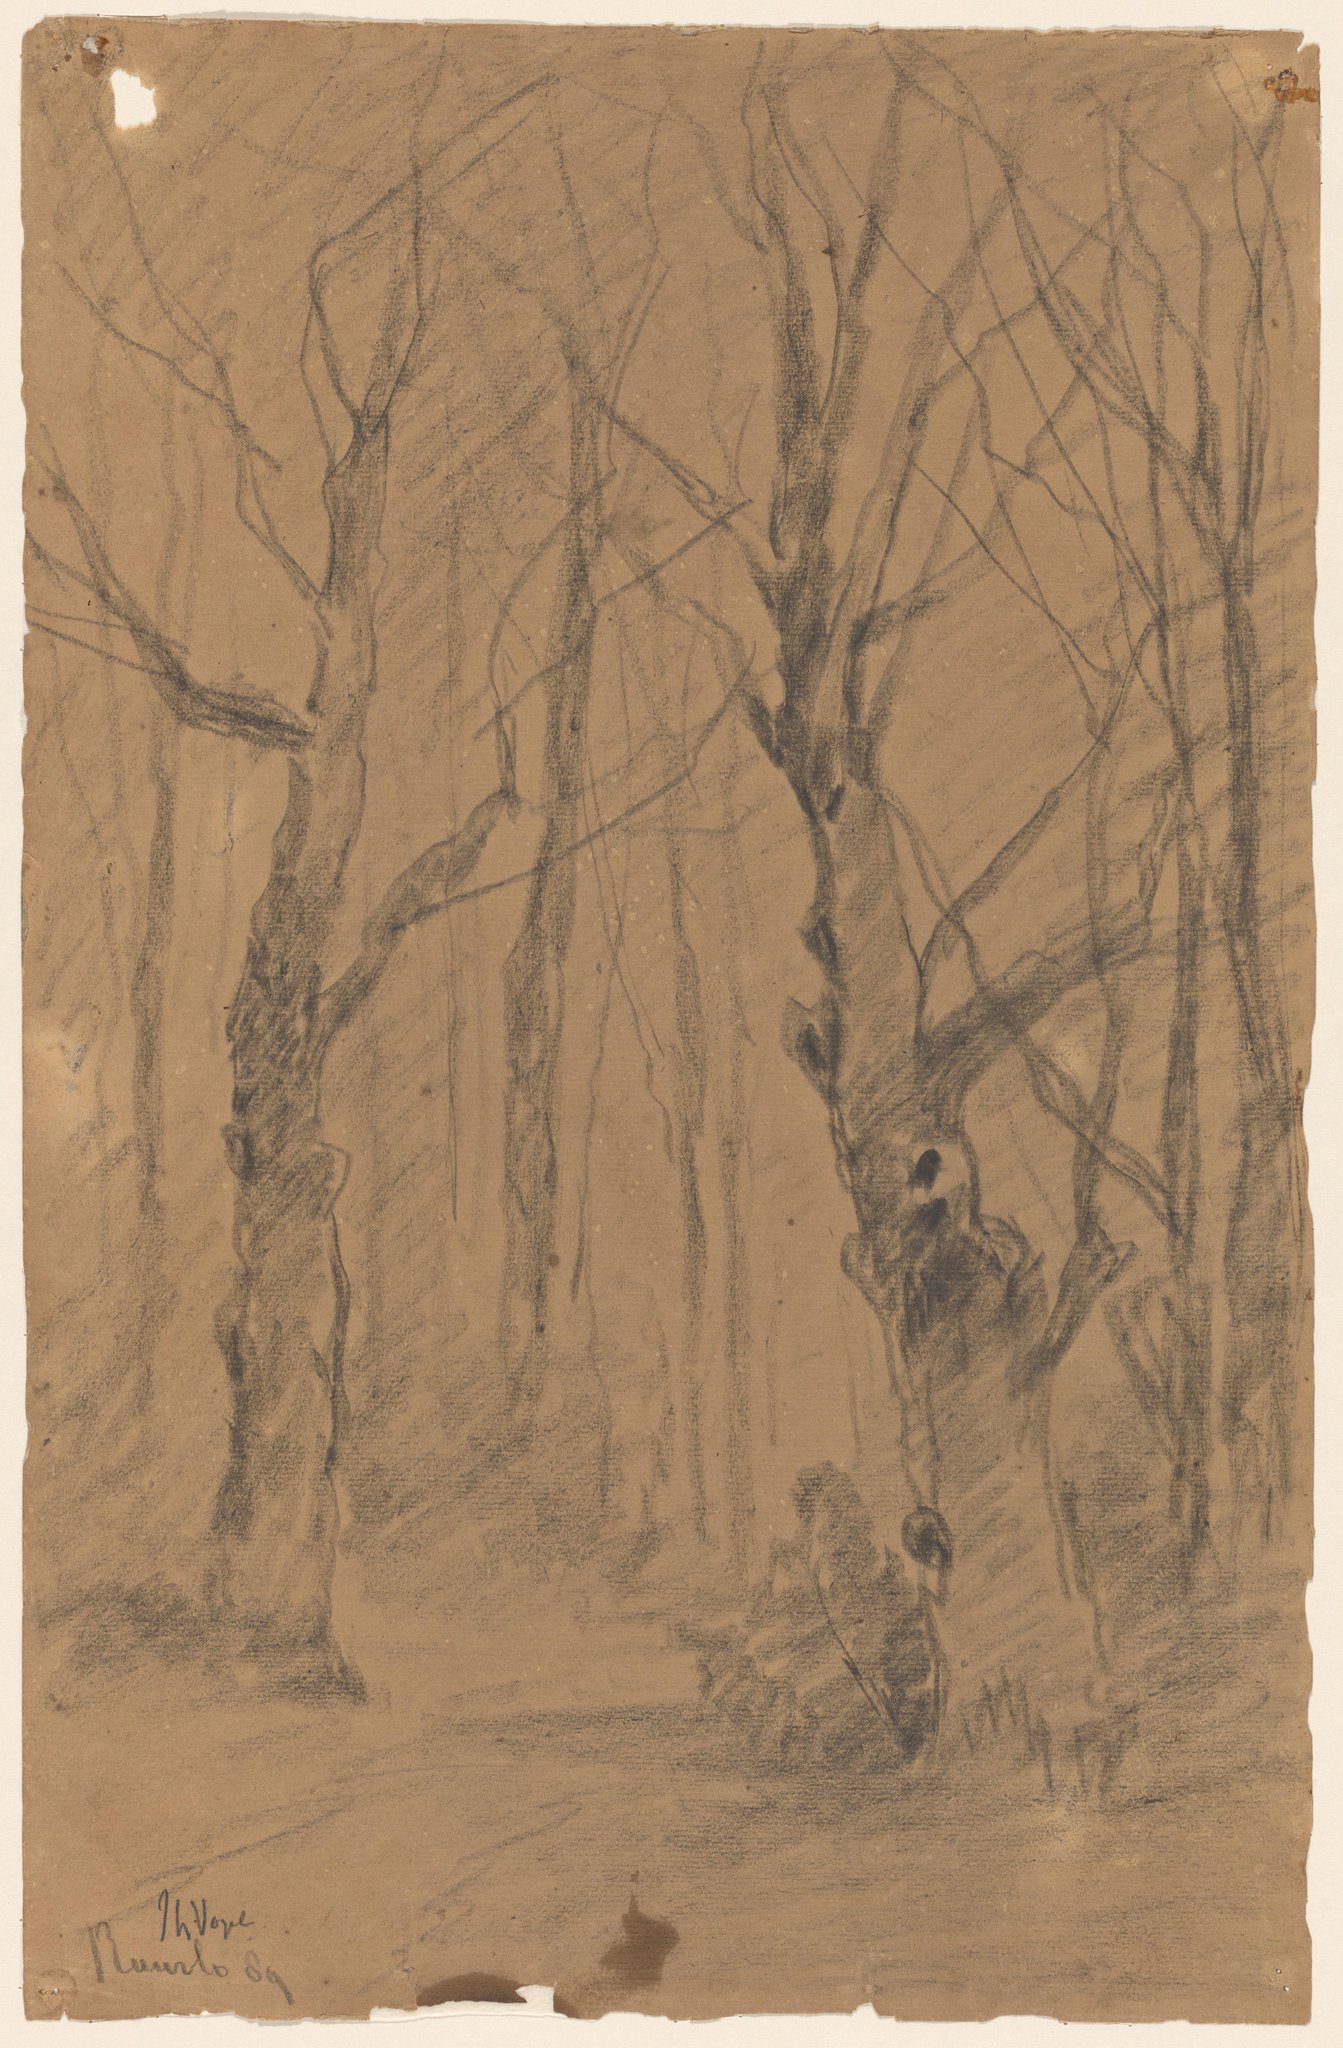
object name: drawing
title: Bomen te Ruurlo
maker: johannes gijsbert vogel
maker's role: draughtsman, painter, print maker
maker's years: 1828-1915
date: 1889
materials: charcoal, paper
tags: trees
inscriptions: date and inscription: ‘Ruurlo 89’, collector's mark: Lugt 1181b